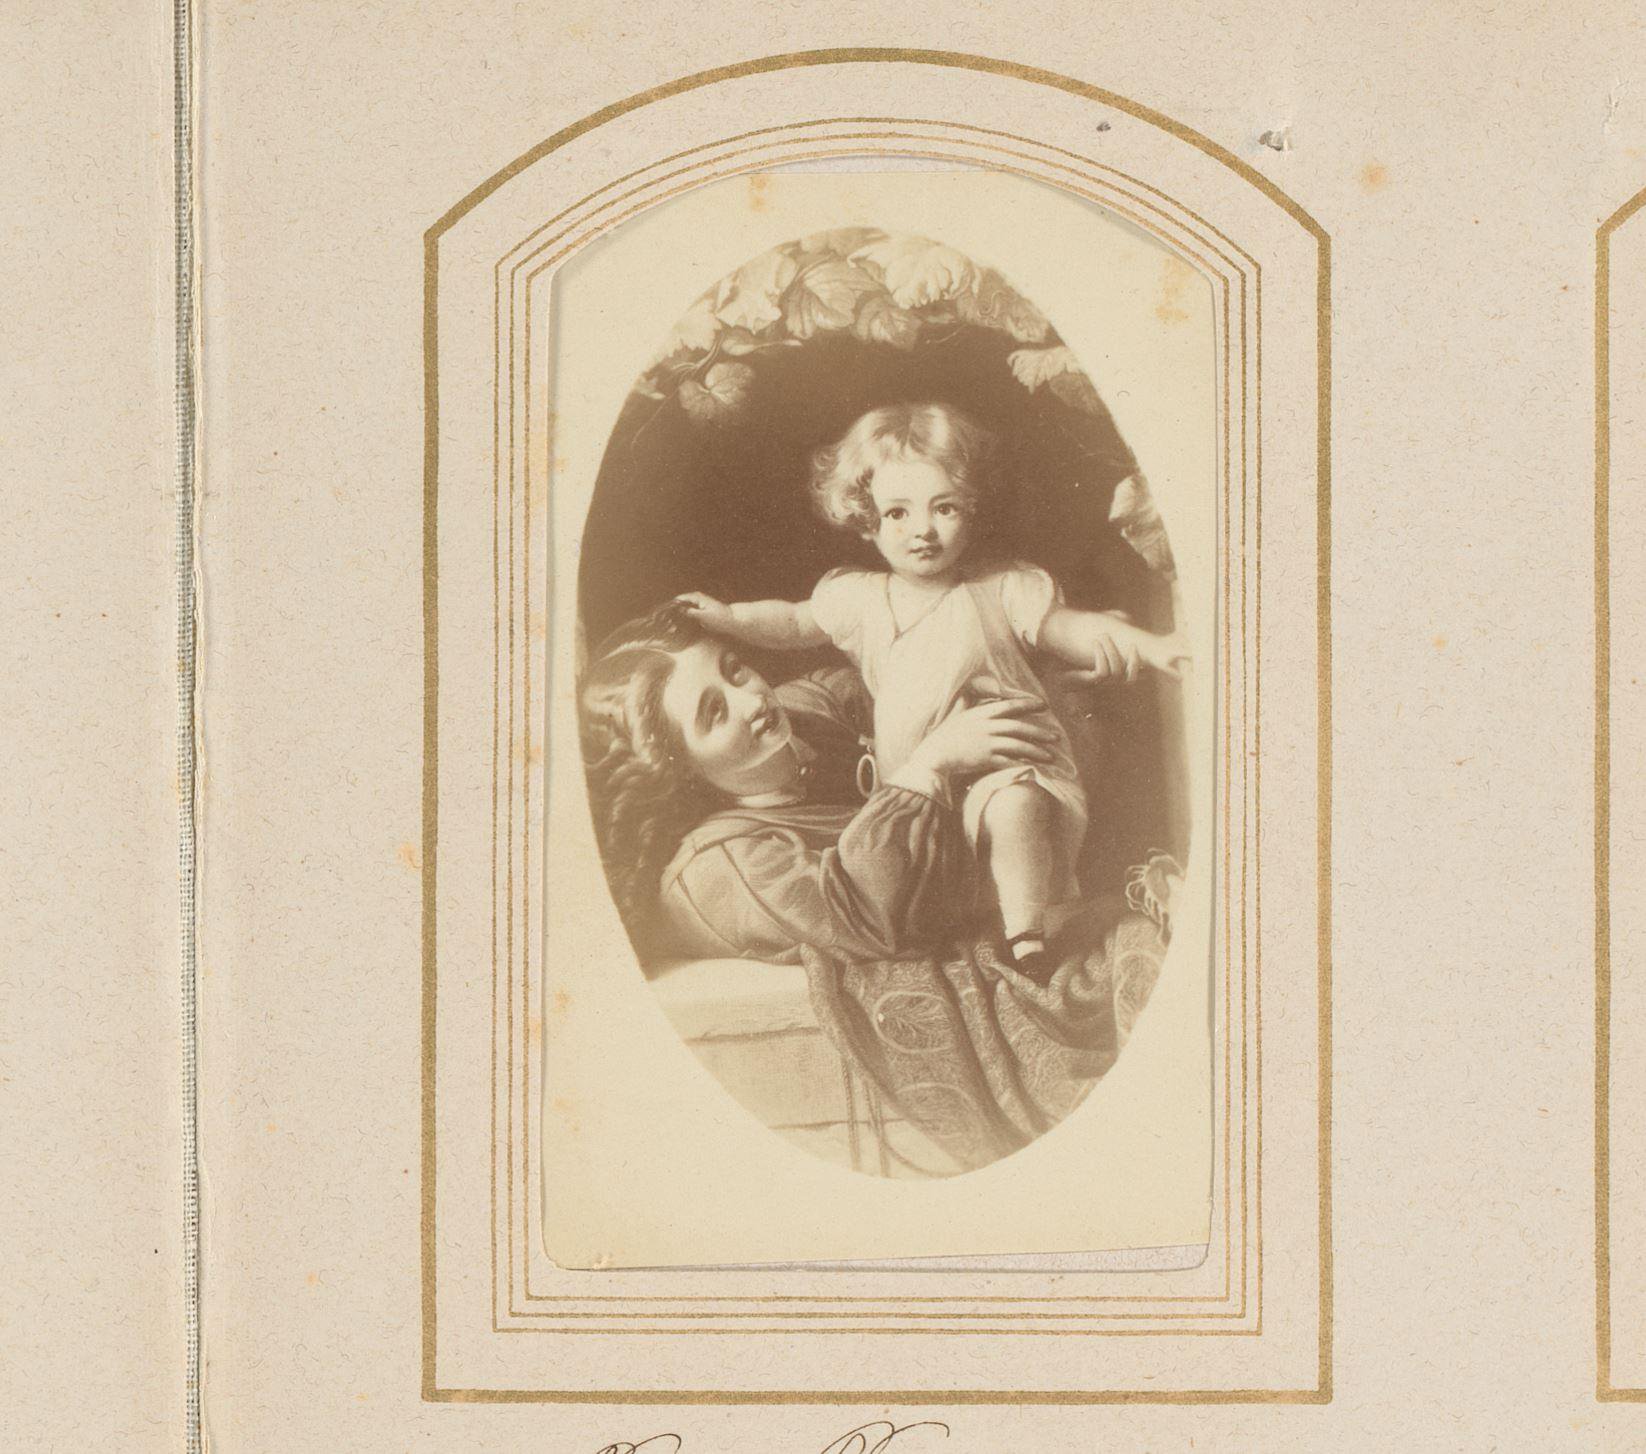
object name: photograph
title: Fotoreproductie van een schilderij van een moeder en kind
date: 1870-1890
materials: cardboard, photographic support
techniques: albumen print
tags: mother and baby or young child, painting, drawing and the graphic arts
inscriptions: annotation: ‘Papa, Papa’, number: ‘1951’